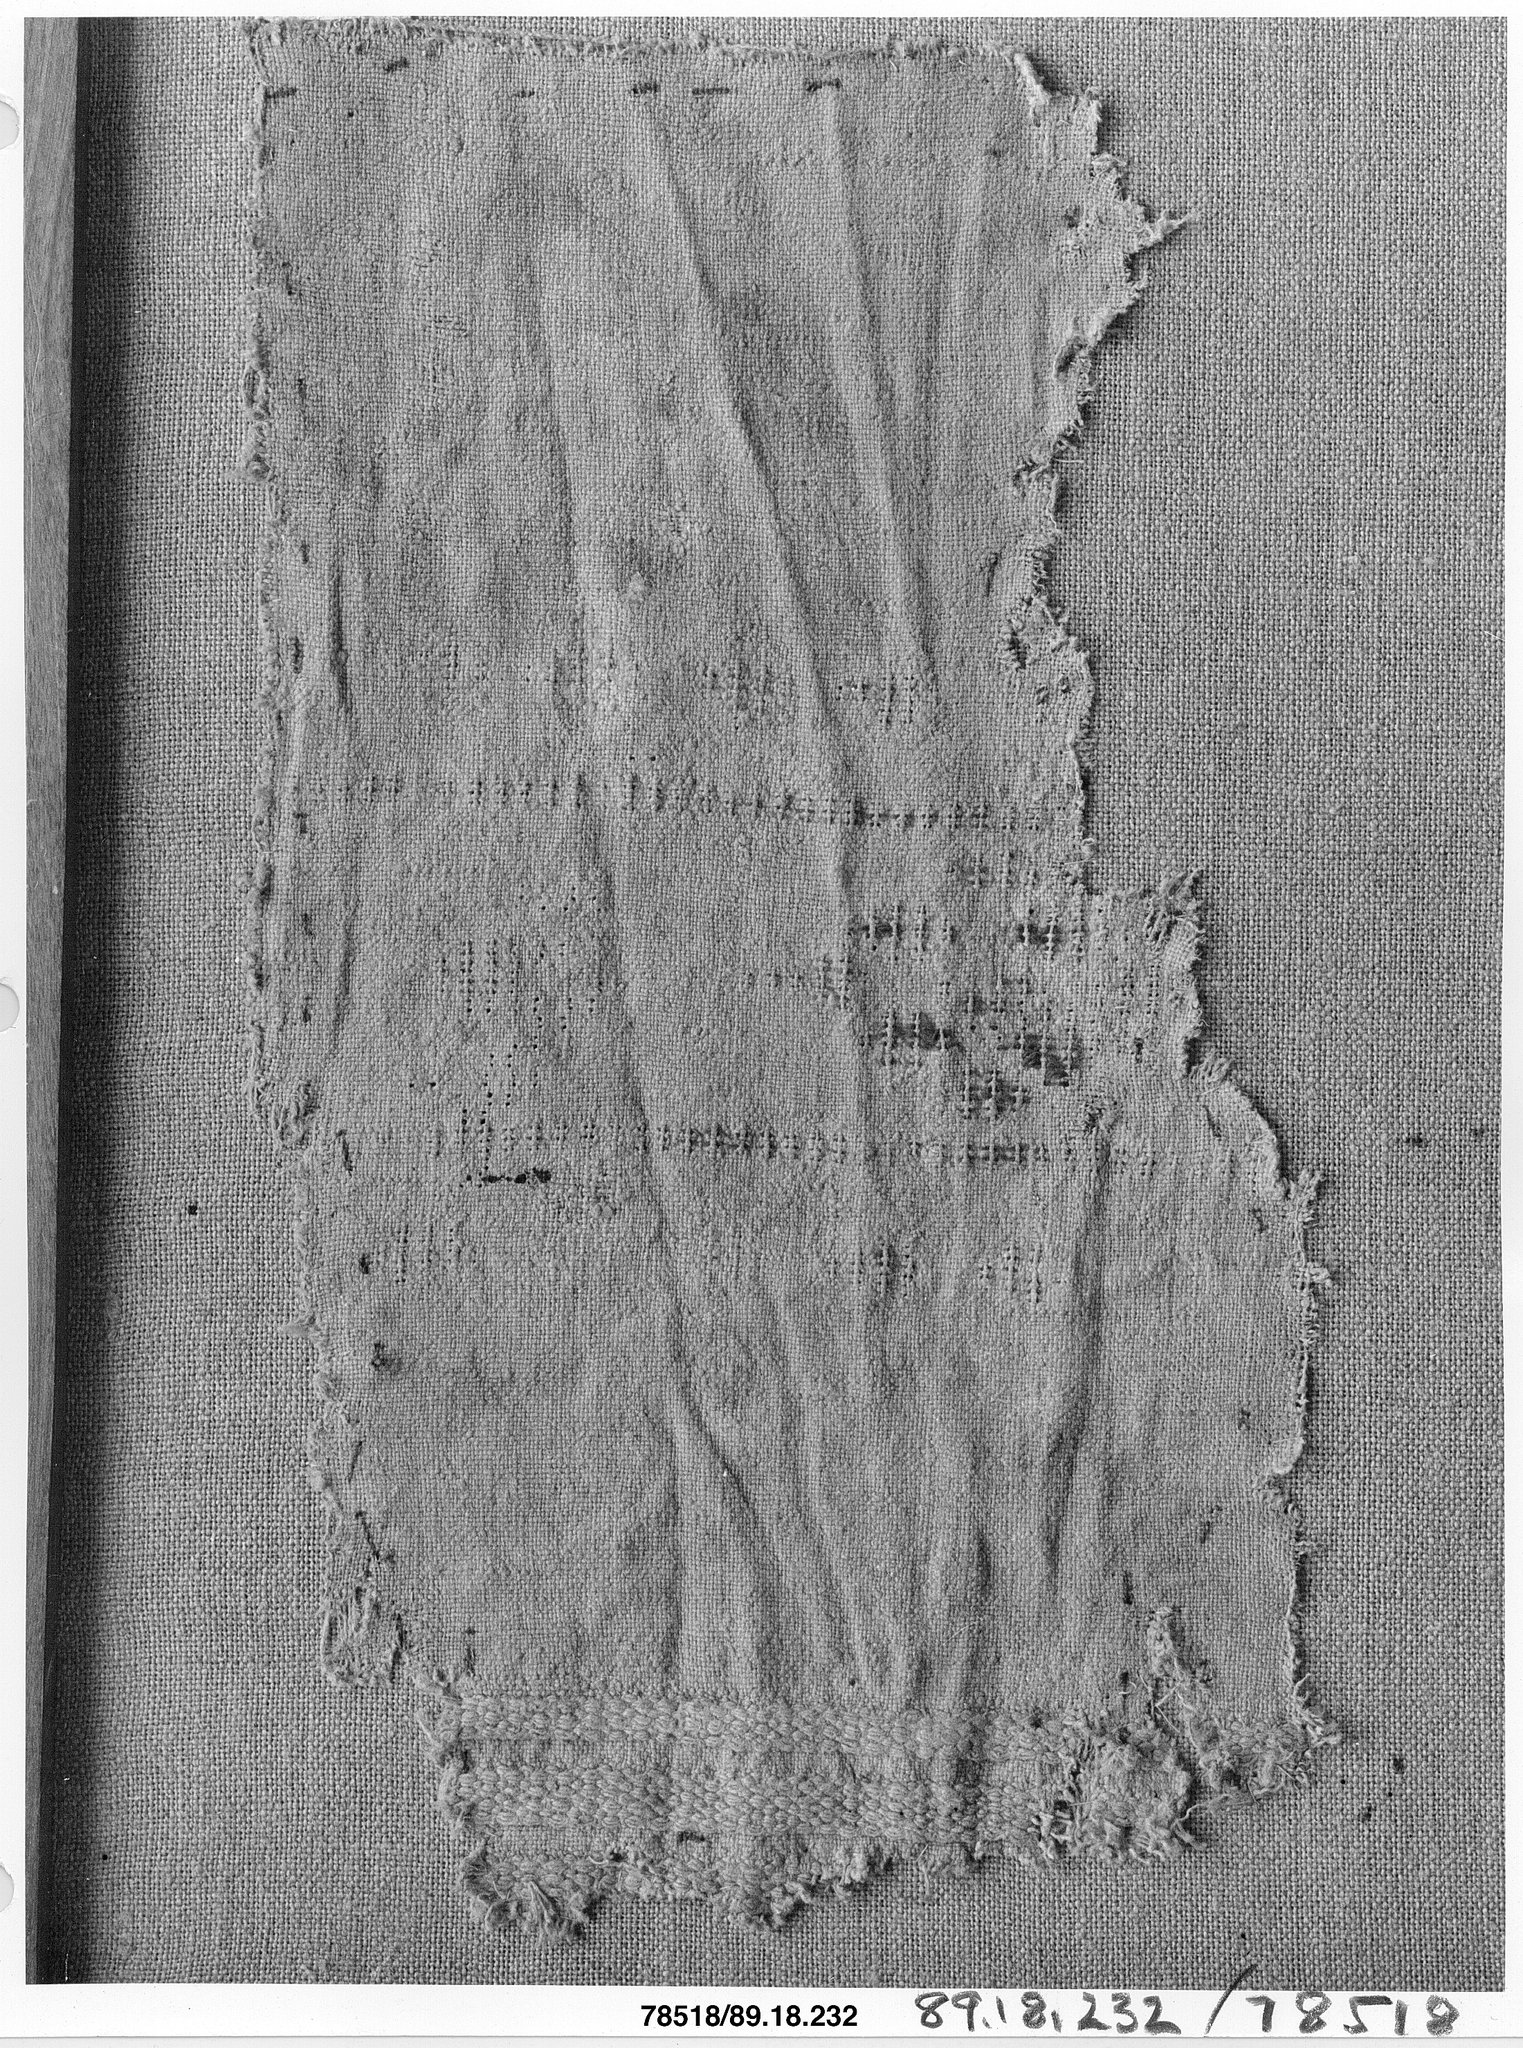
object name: textile fragment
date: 401-600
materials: linen, wool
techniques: weave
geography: egypt